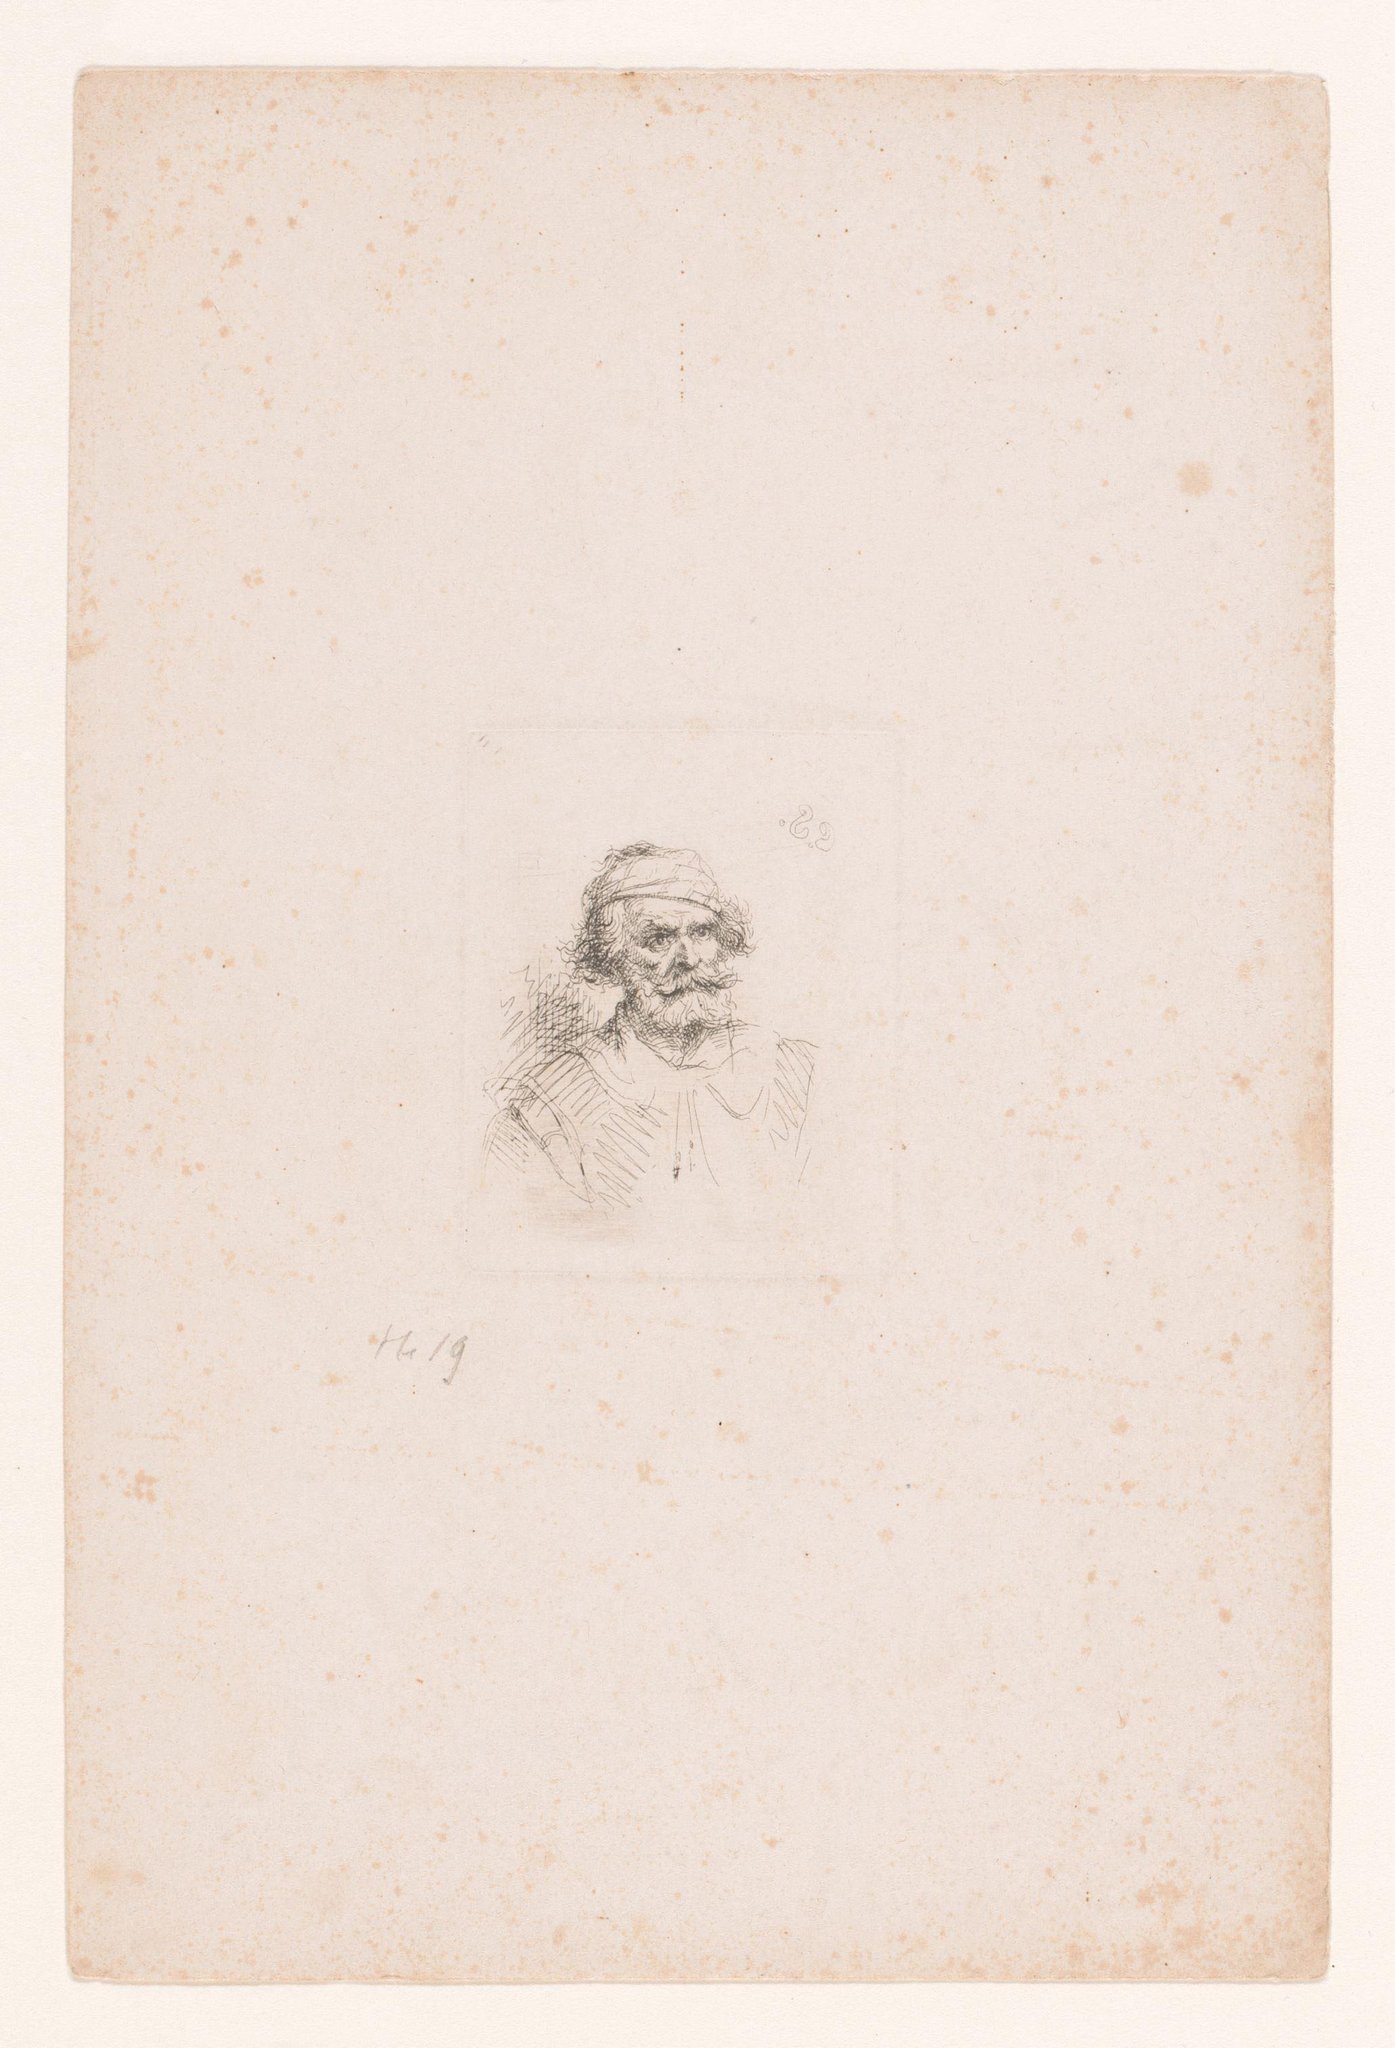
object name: print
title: Portret van een onbekende edelman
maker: corneille seghers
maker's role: draughtsman, print maker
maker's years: 1814-1869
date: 1824-1869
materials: paper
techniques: etching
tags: anonymous historical person portrayed alone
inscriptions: collector's mark: Lugt 2228, collector's mark: Lugt 1485